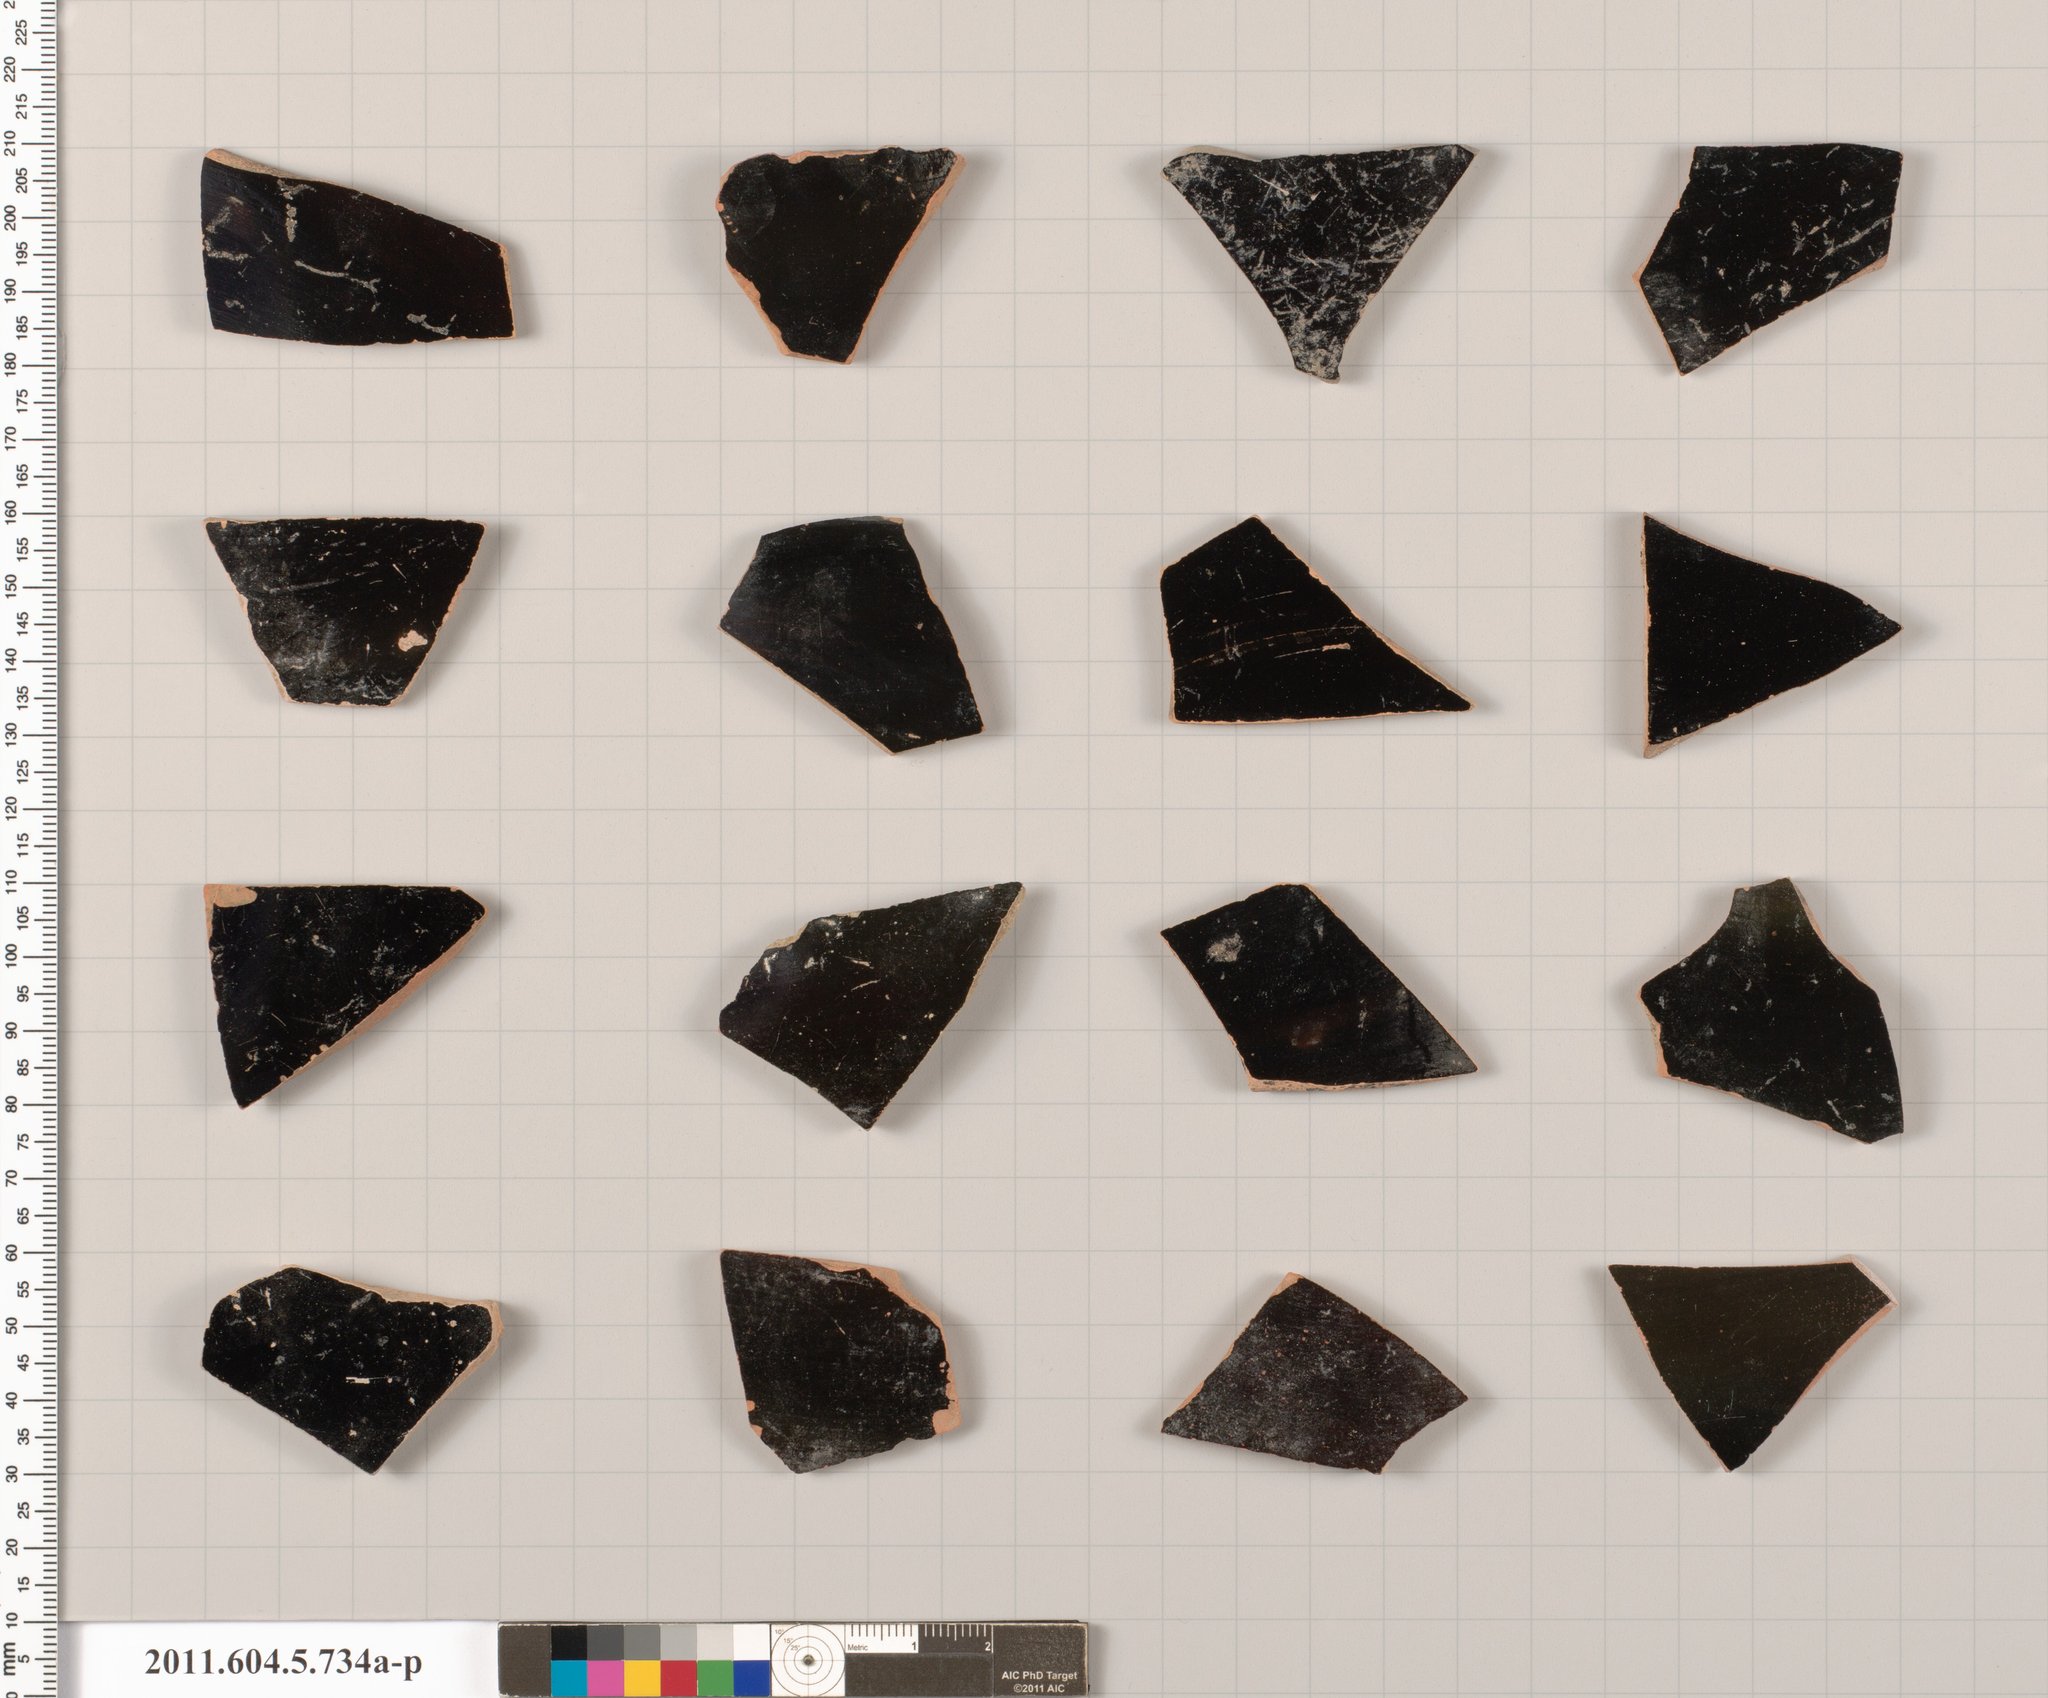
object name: kylix fragment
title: Terracotta fragments of kylikes (drinking cups)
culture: greek, attic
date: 600-401 BCE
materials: terracotta